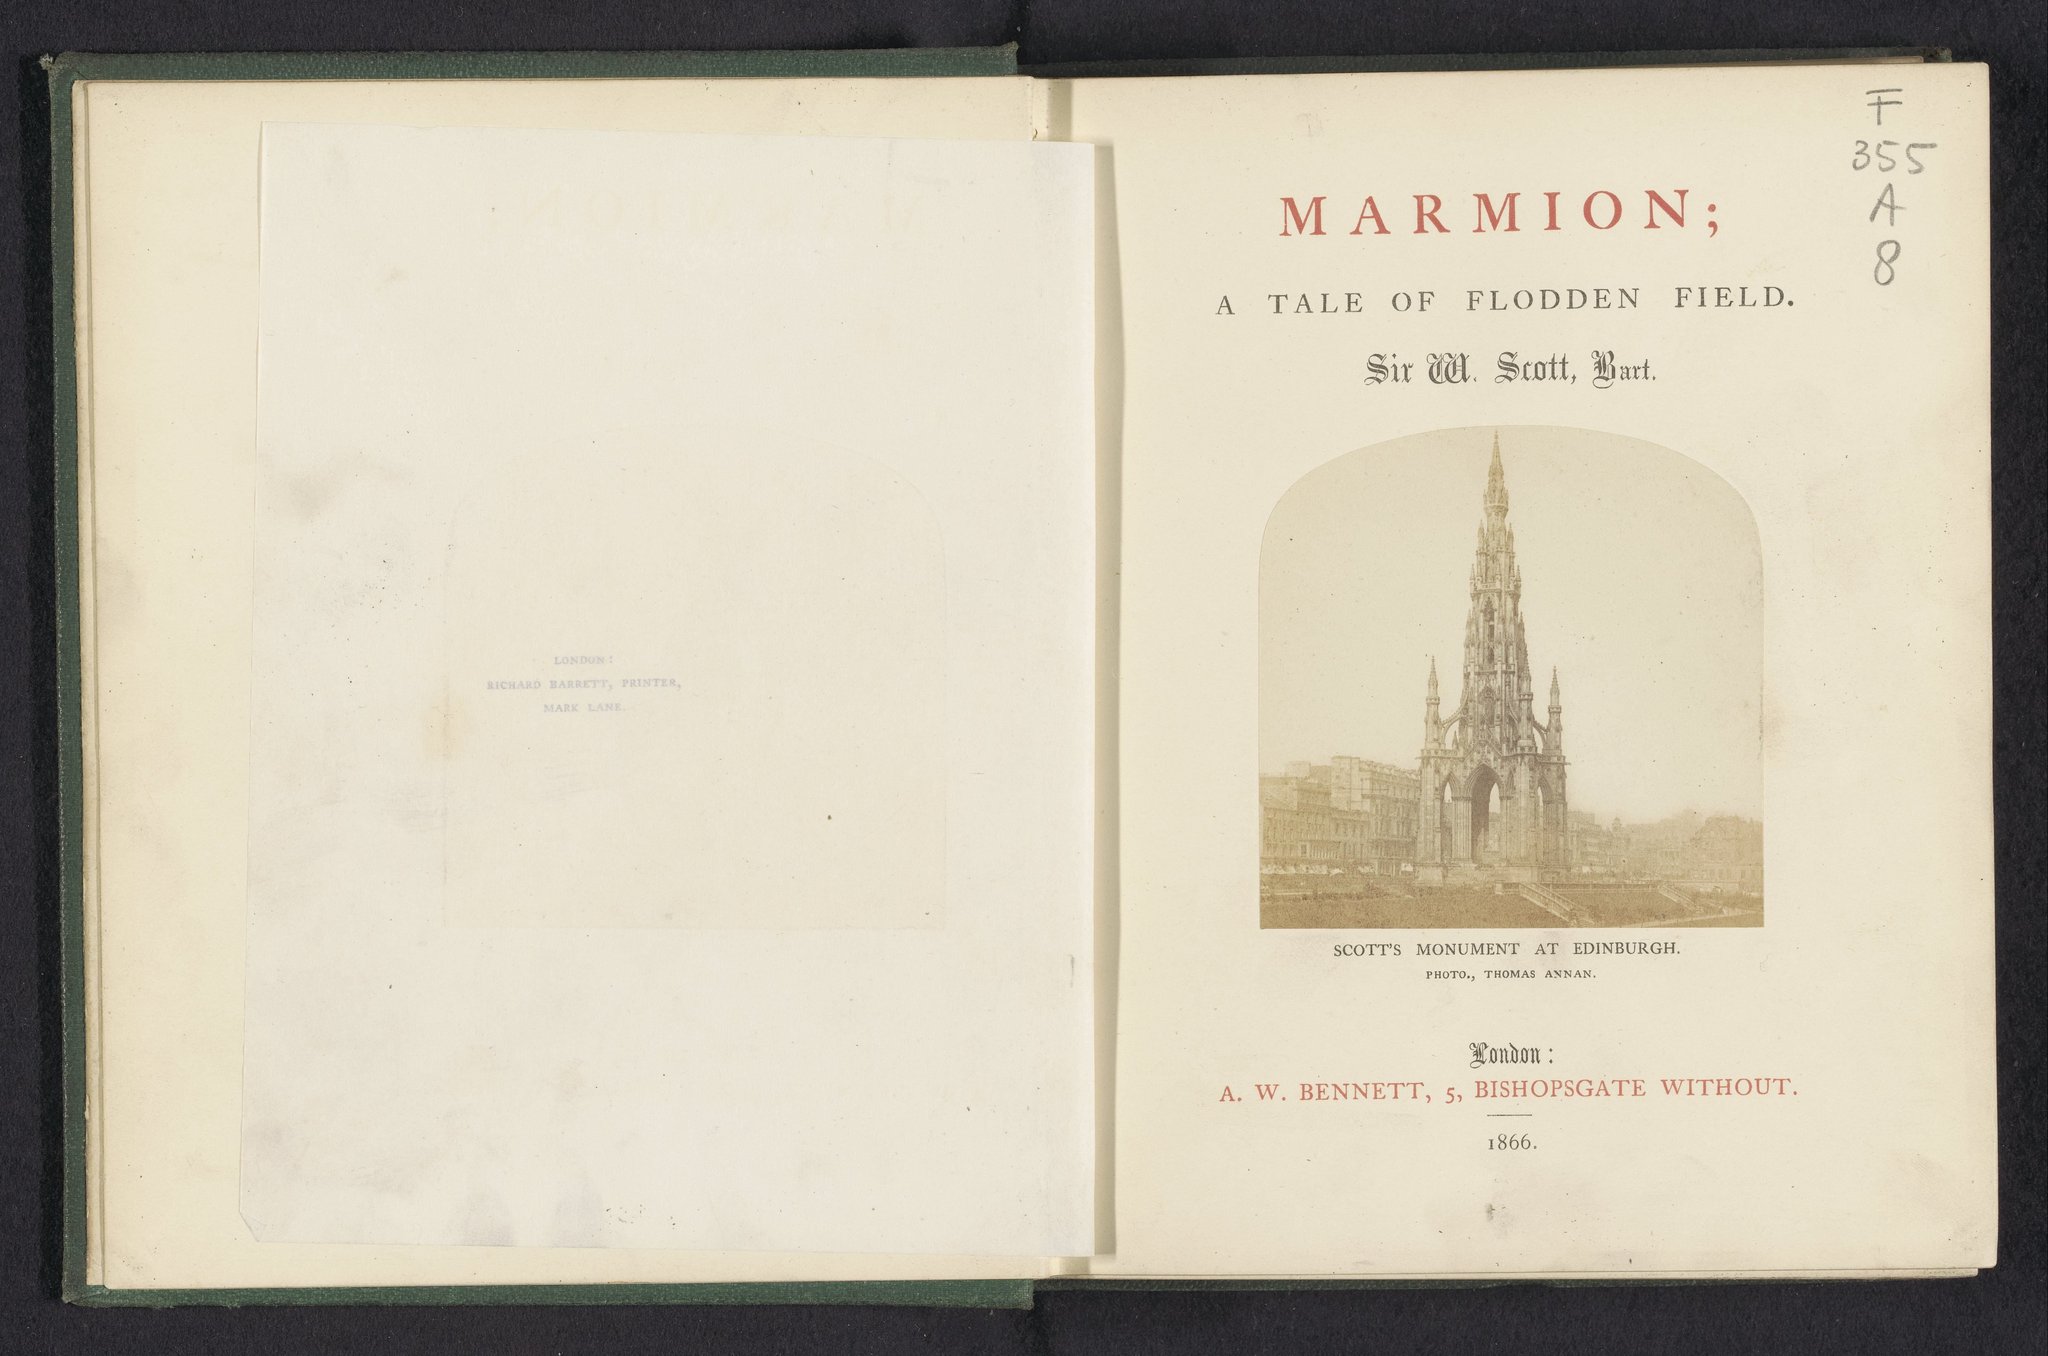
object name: book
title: Marmion : a tale of Flodden Field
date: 1866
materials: linen, paper, photographic support, wood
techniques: albumen print, printing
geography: london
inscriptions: inscription: ‘Edwin Slater Market St Manchester’